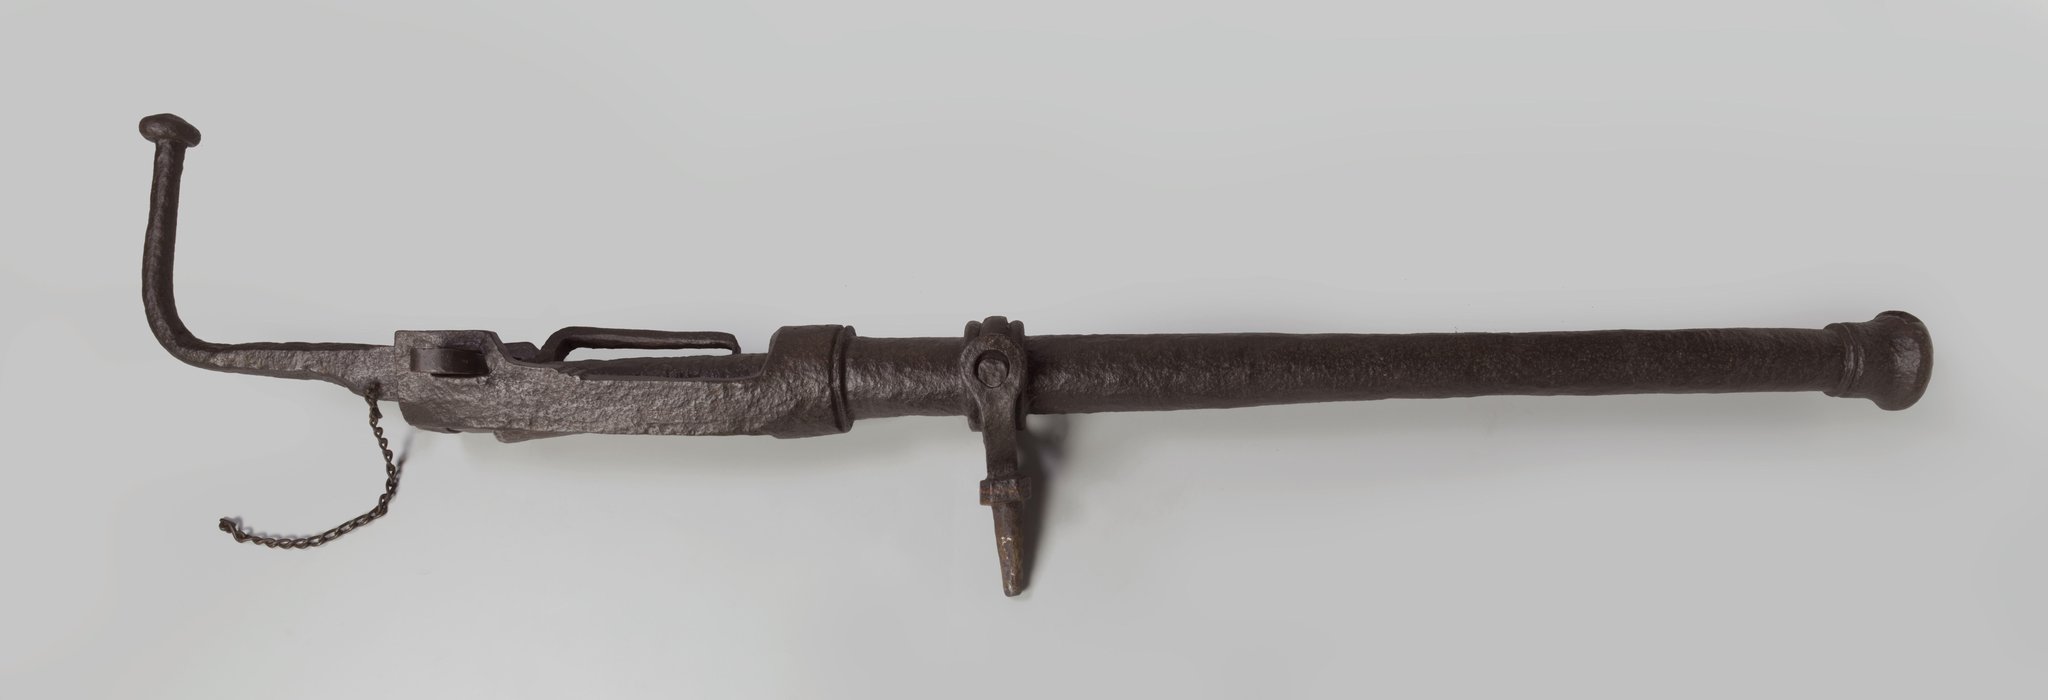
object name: harquebus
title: Haakbus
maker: Anonymous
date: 1500-1700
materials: iron, wood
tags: haarlemmermeer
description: Haakbus met losse kamer. Voghelaar(?). Geplaatst op een affuit.